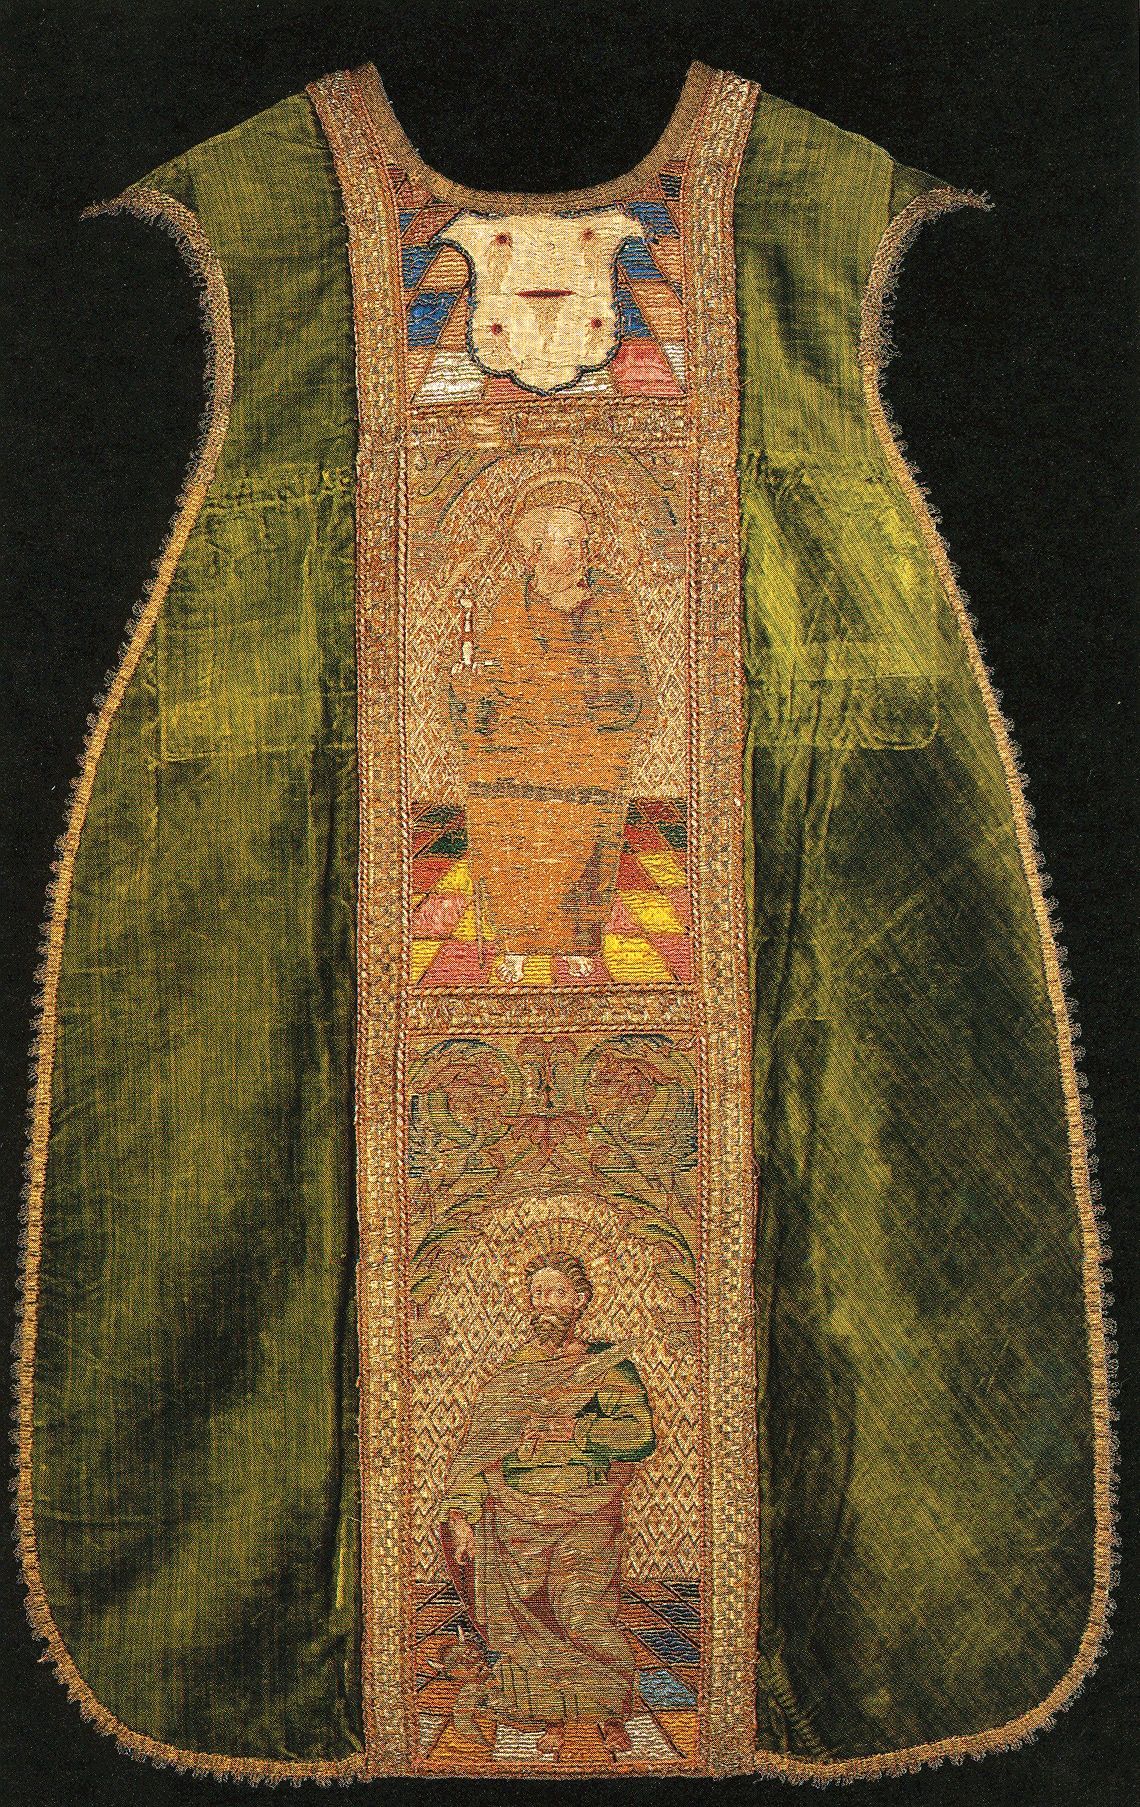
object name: chasuble with orphrey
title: Chasuble with Orphreys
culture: spanish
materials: linen, metal, silk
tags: men,saints